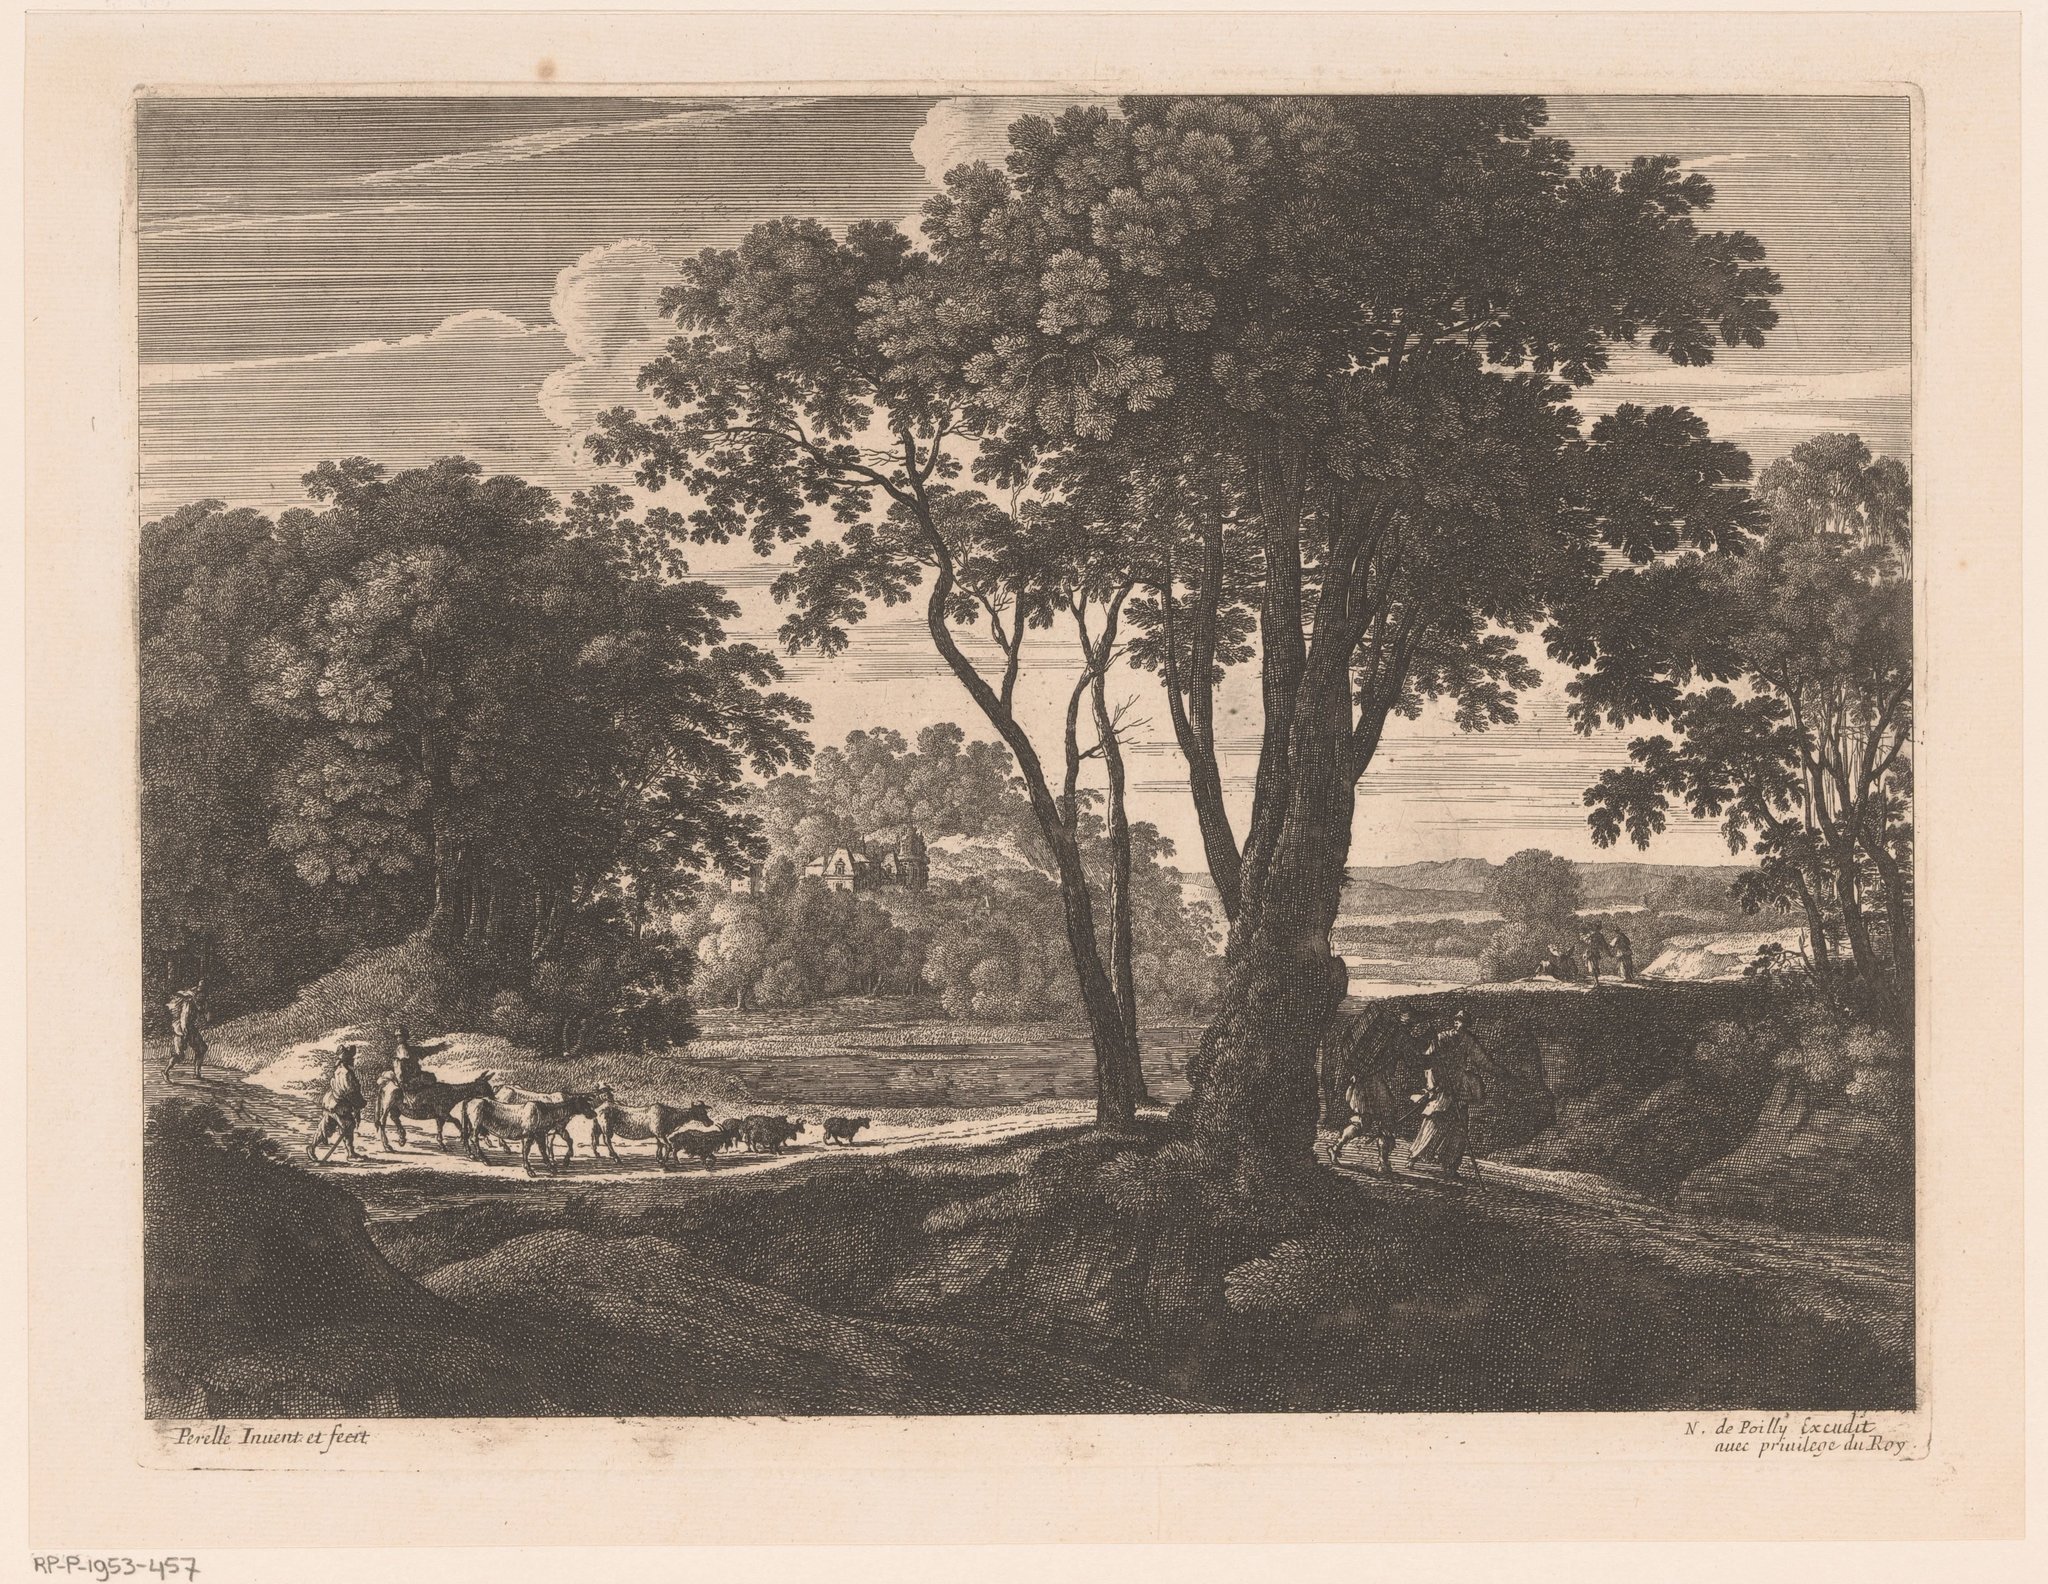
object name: print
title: Herders met kudde vee op landweg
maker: nicolas de poilly (i)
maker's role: print maker, publisher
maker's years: 1626-1696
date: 1636-1695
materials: paper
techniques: engraving, etching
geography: paris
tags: landscapes, road, path, herd, flock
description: Prenten met het signatuur 'Perelle' kunnen zowel door vader Gabriel als door zonen Nicolas en Adam gemaakt zijn.